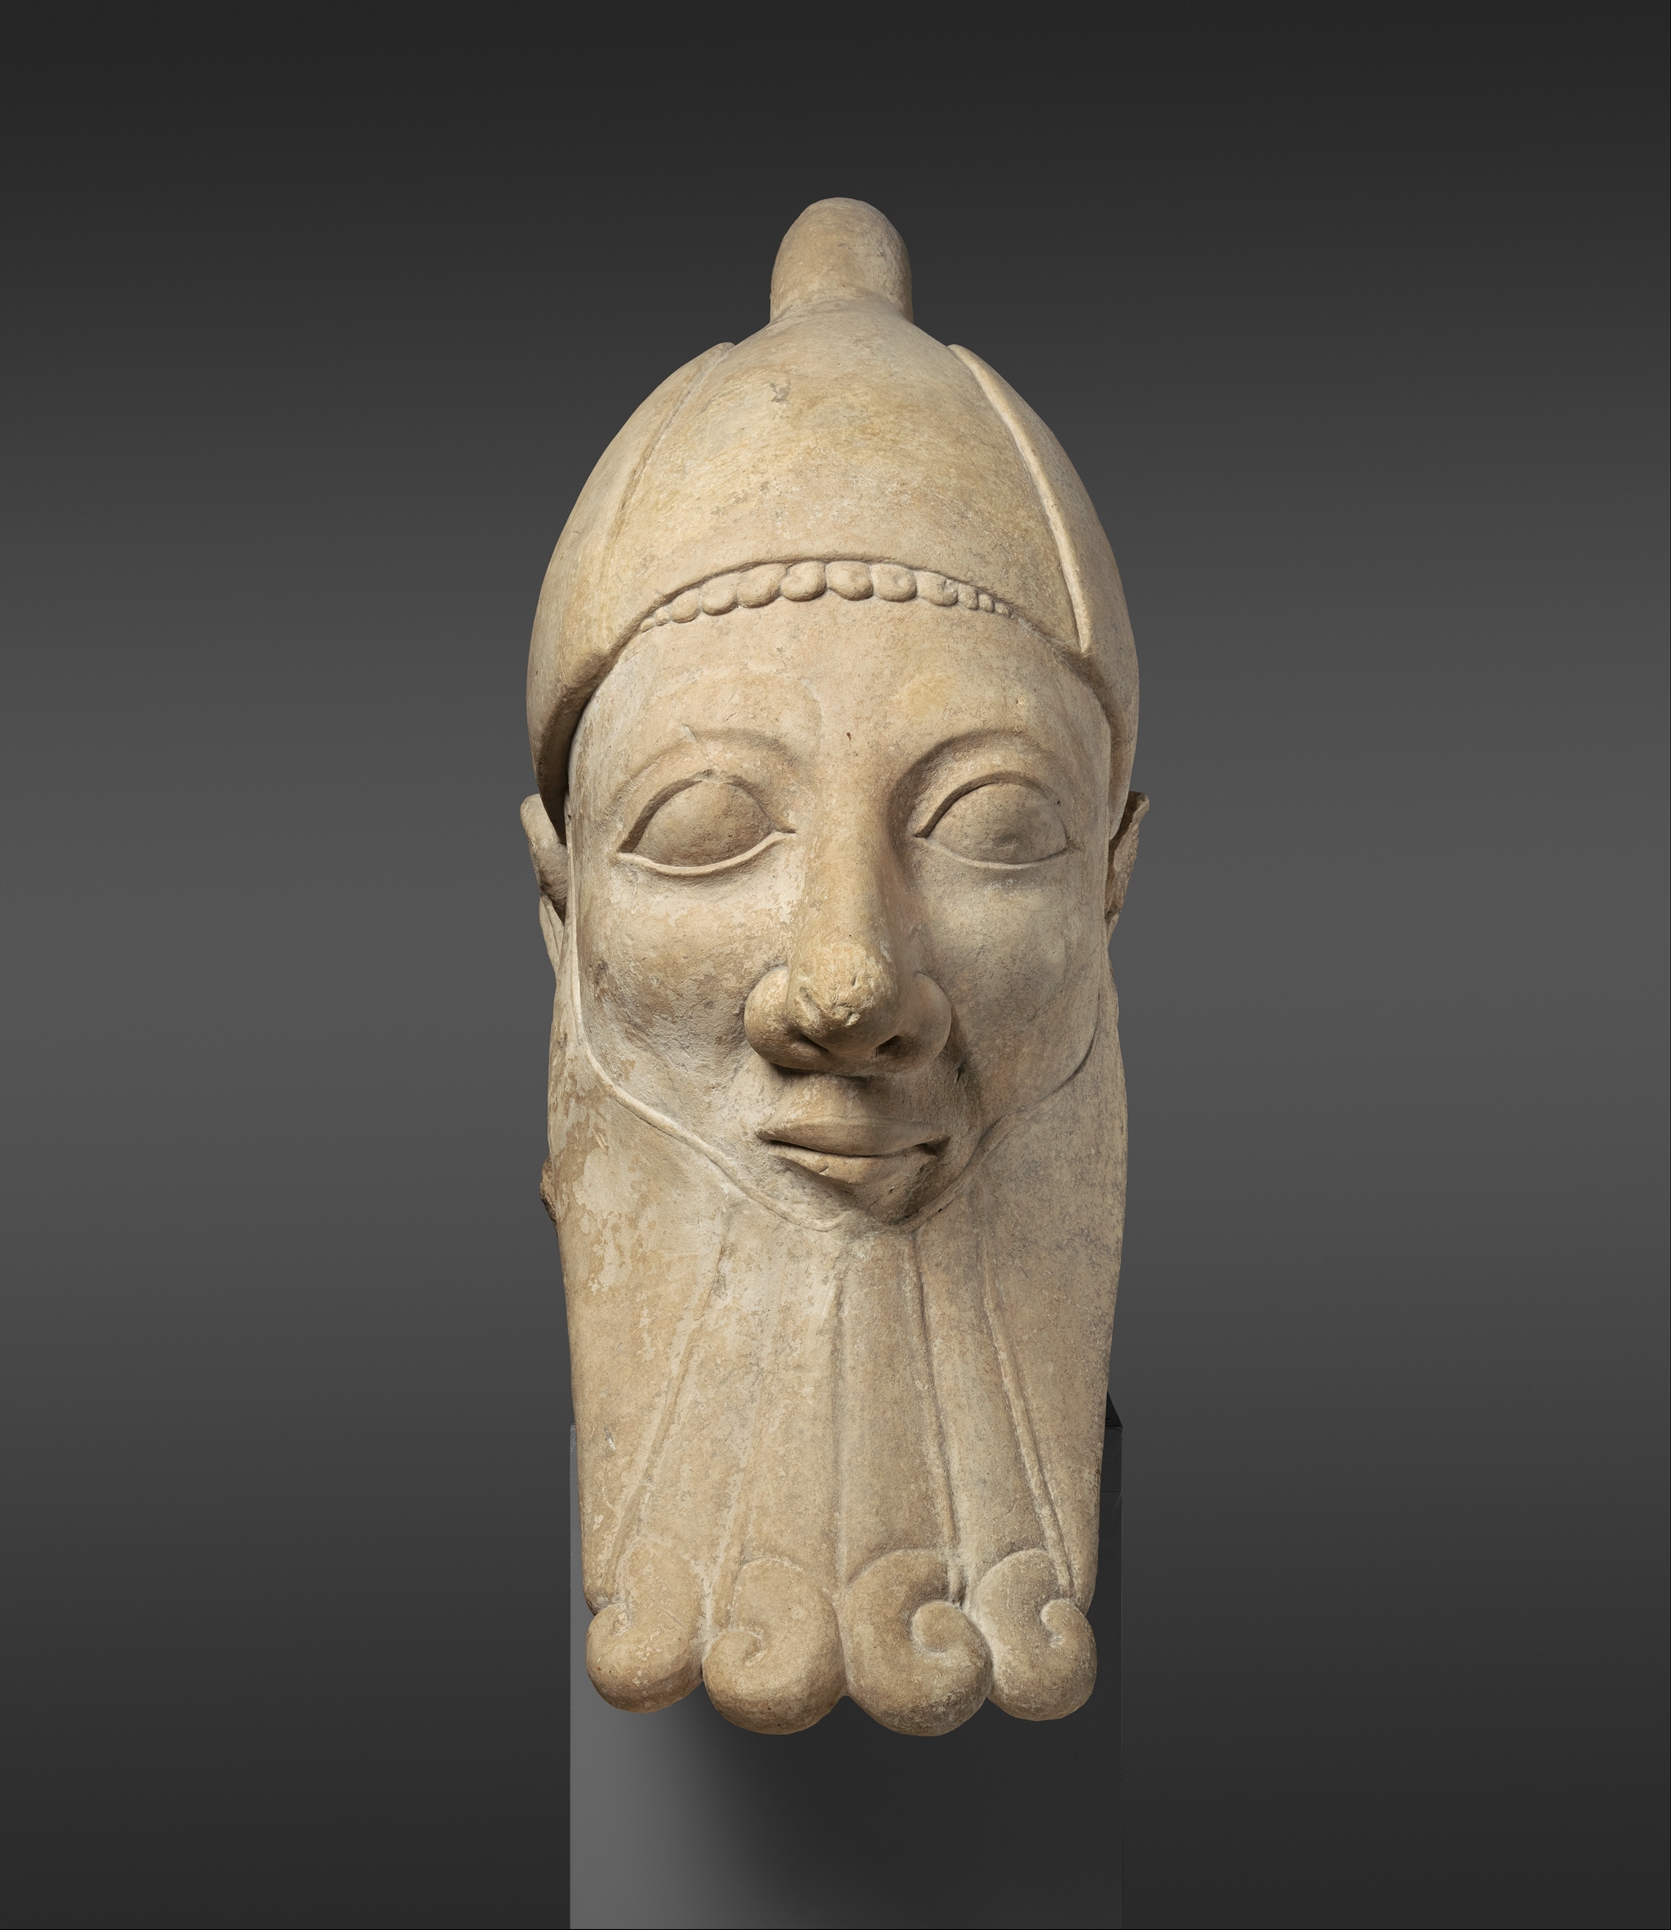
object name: head of a bearded man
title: Limestone head of a bearded man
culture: cypriot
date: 600-568 BCE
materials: limestone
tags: heads,men